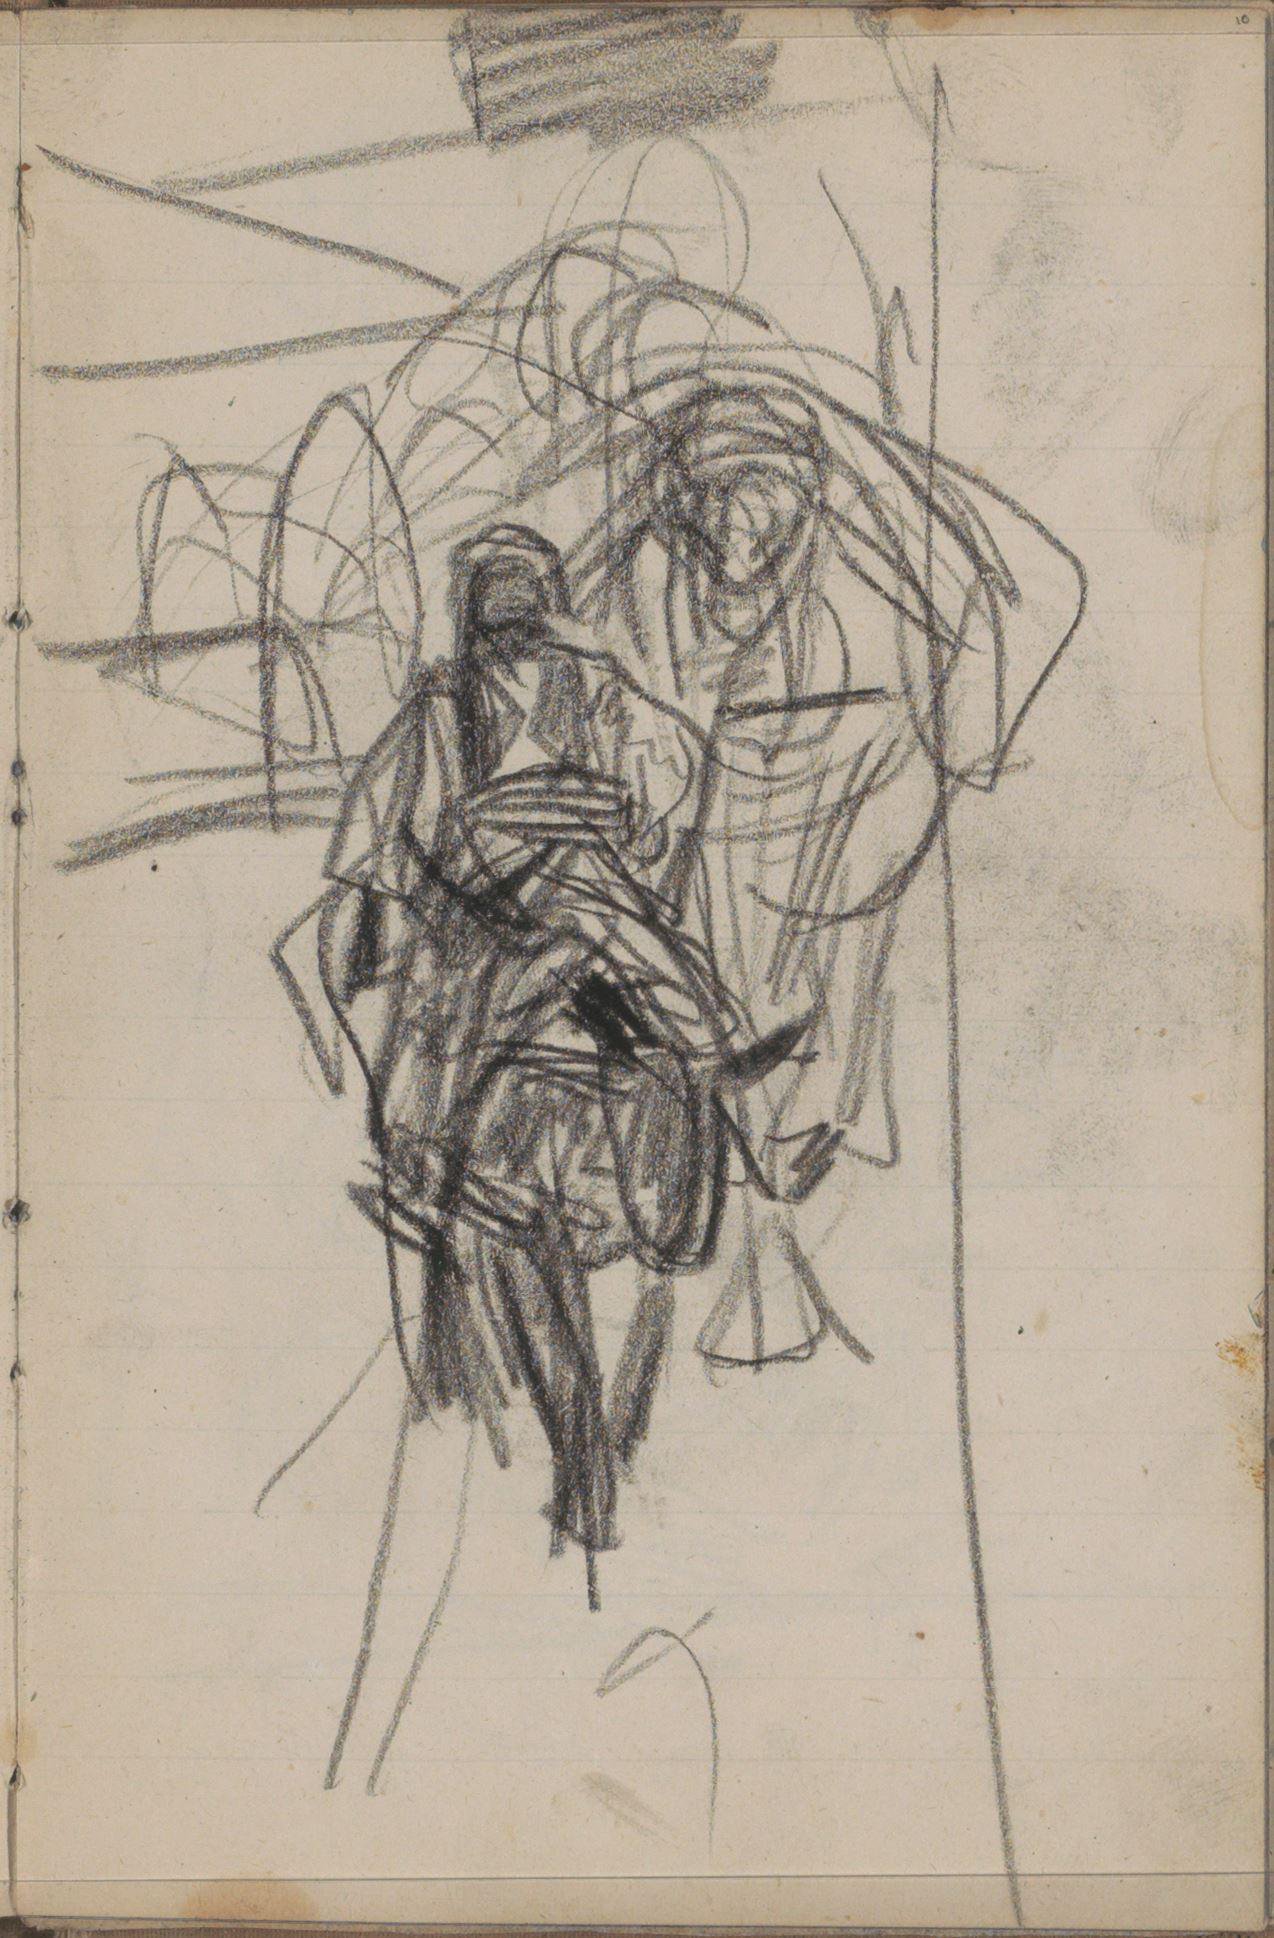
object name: sketchbook leaf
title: Figuur op een ezel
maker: marius bauer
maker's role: draughtsman, print maker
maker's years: 1867-1932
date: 1888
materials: chalk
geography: istanbul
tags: riding a horse, ass, or mule; rider, horseman, asiatic races and peoples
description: Pagina 10 uit een schetsboek met 58 bladen.